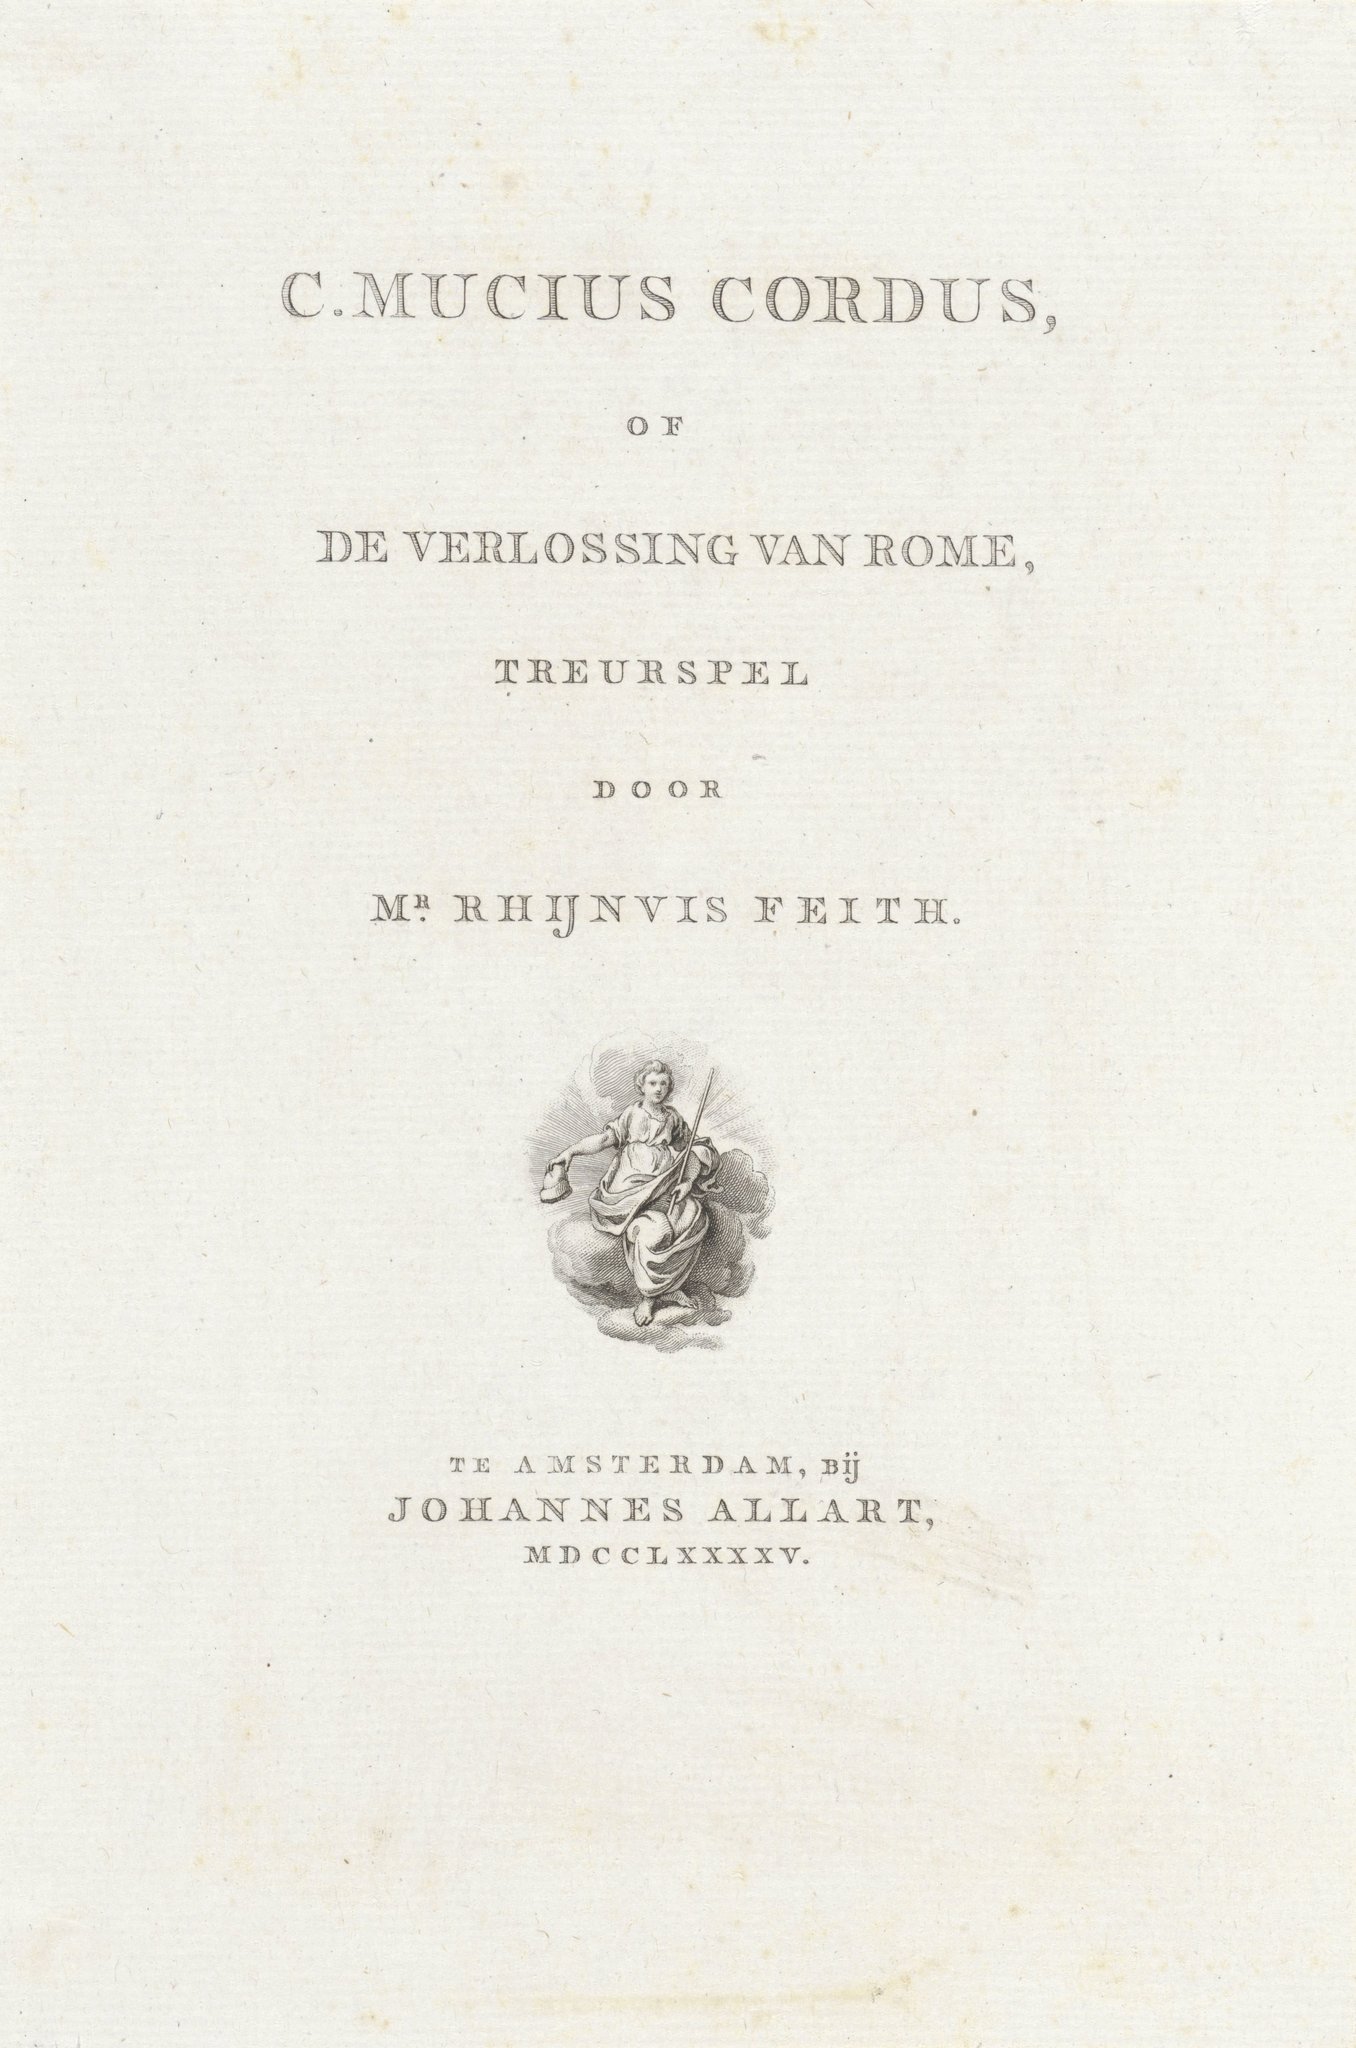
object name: titelblad, titelpagina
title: Titelpagina voor: Rhijnvis Feith 'C. Mucius Cordus, of De Verlossing van Rome', 1795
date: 1795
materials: paper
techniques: etching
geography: amsterdam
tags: freedom, liberty; 'libertà' (ripa) (+ symbolical representation of concept)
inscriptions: collector's mark: Lugt 240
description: Titelpagina voor: Feith, Rhijnvis. C. Mucius Cordus, of De verlossing van Rome. Amsterdam: Johannes Allart, 1795.